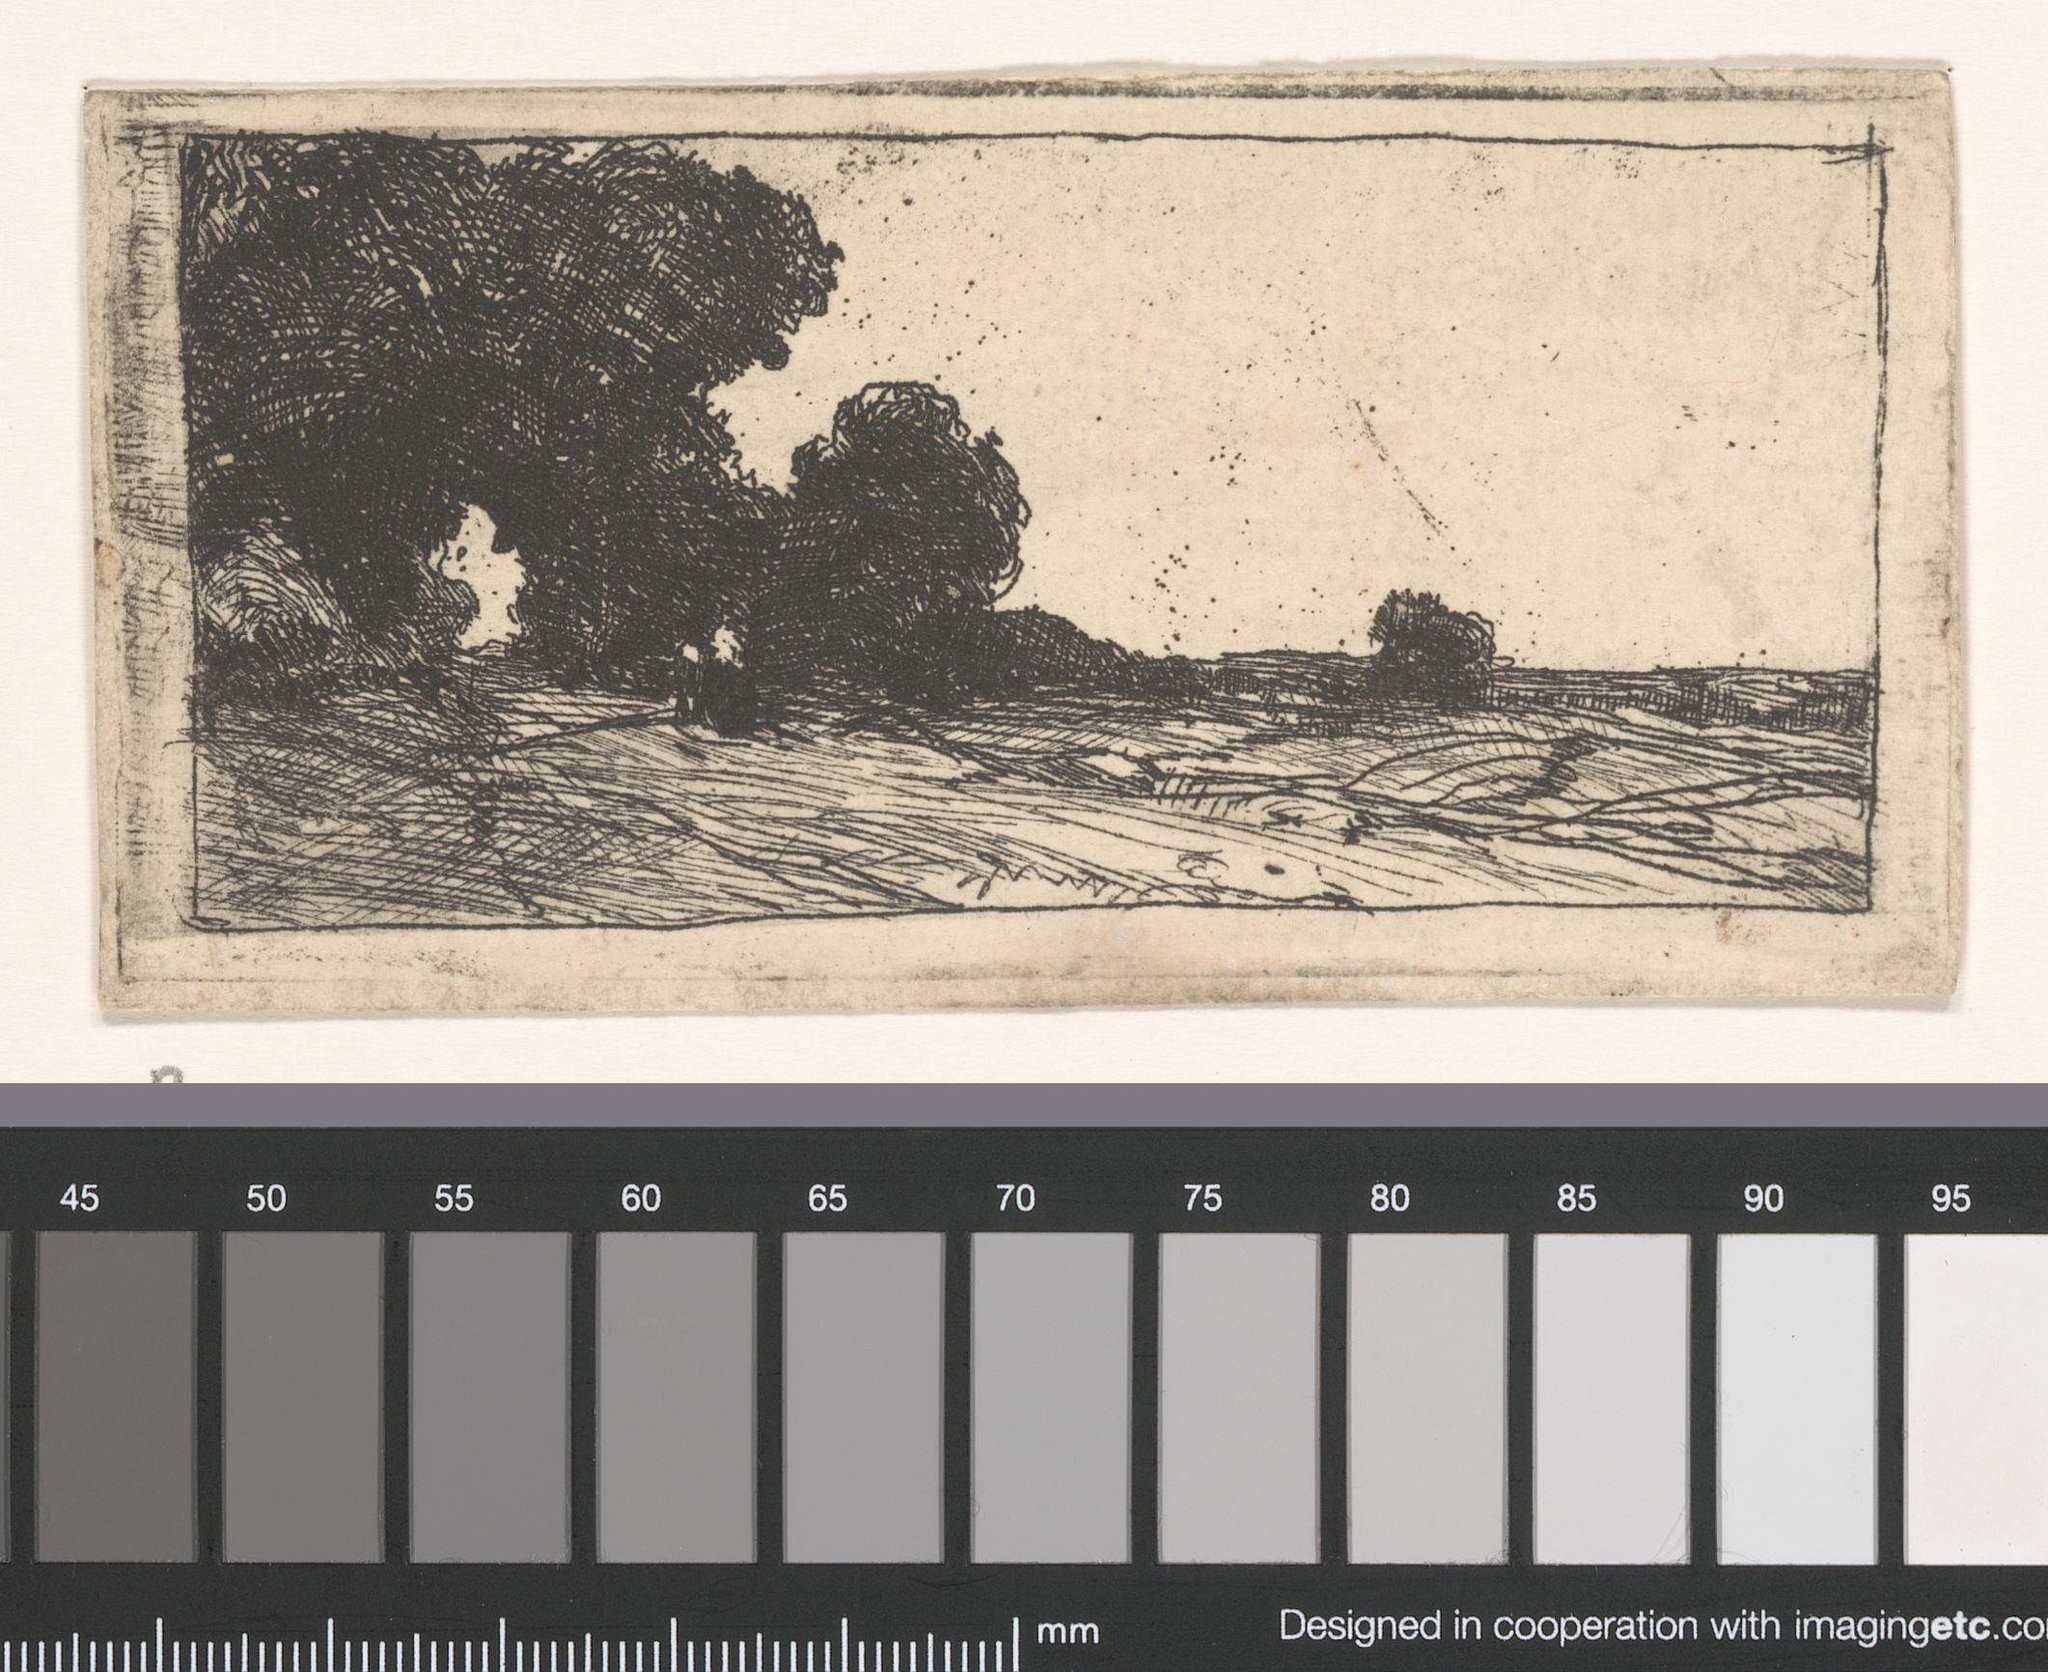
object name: print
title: Landschap met bomen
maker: chris van der windt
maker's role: print maker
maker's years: 1877-1952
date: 1887-1952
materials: paper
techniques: etching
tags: meadow, pasture - hh - ideal landscapes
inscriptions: collector's mark: Lugt 2228